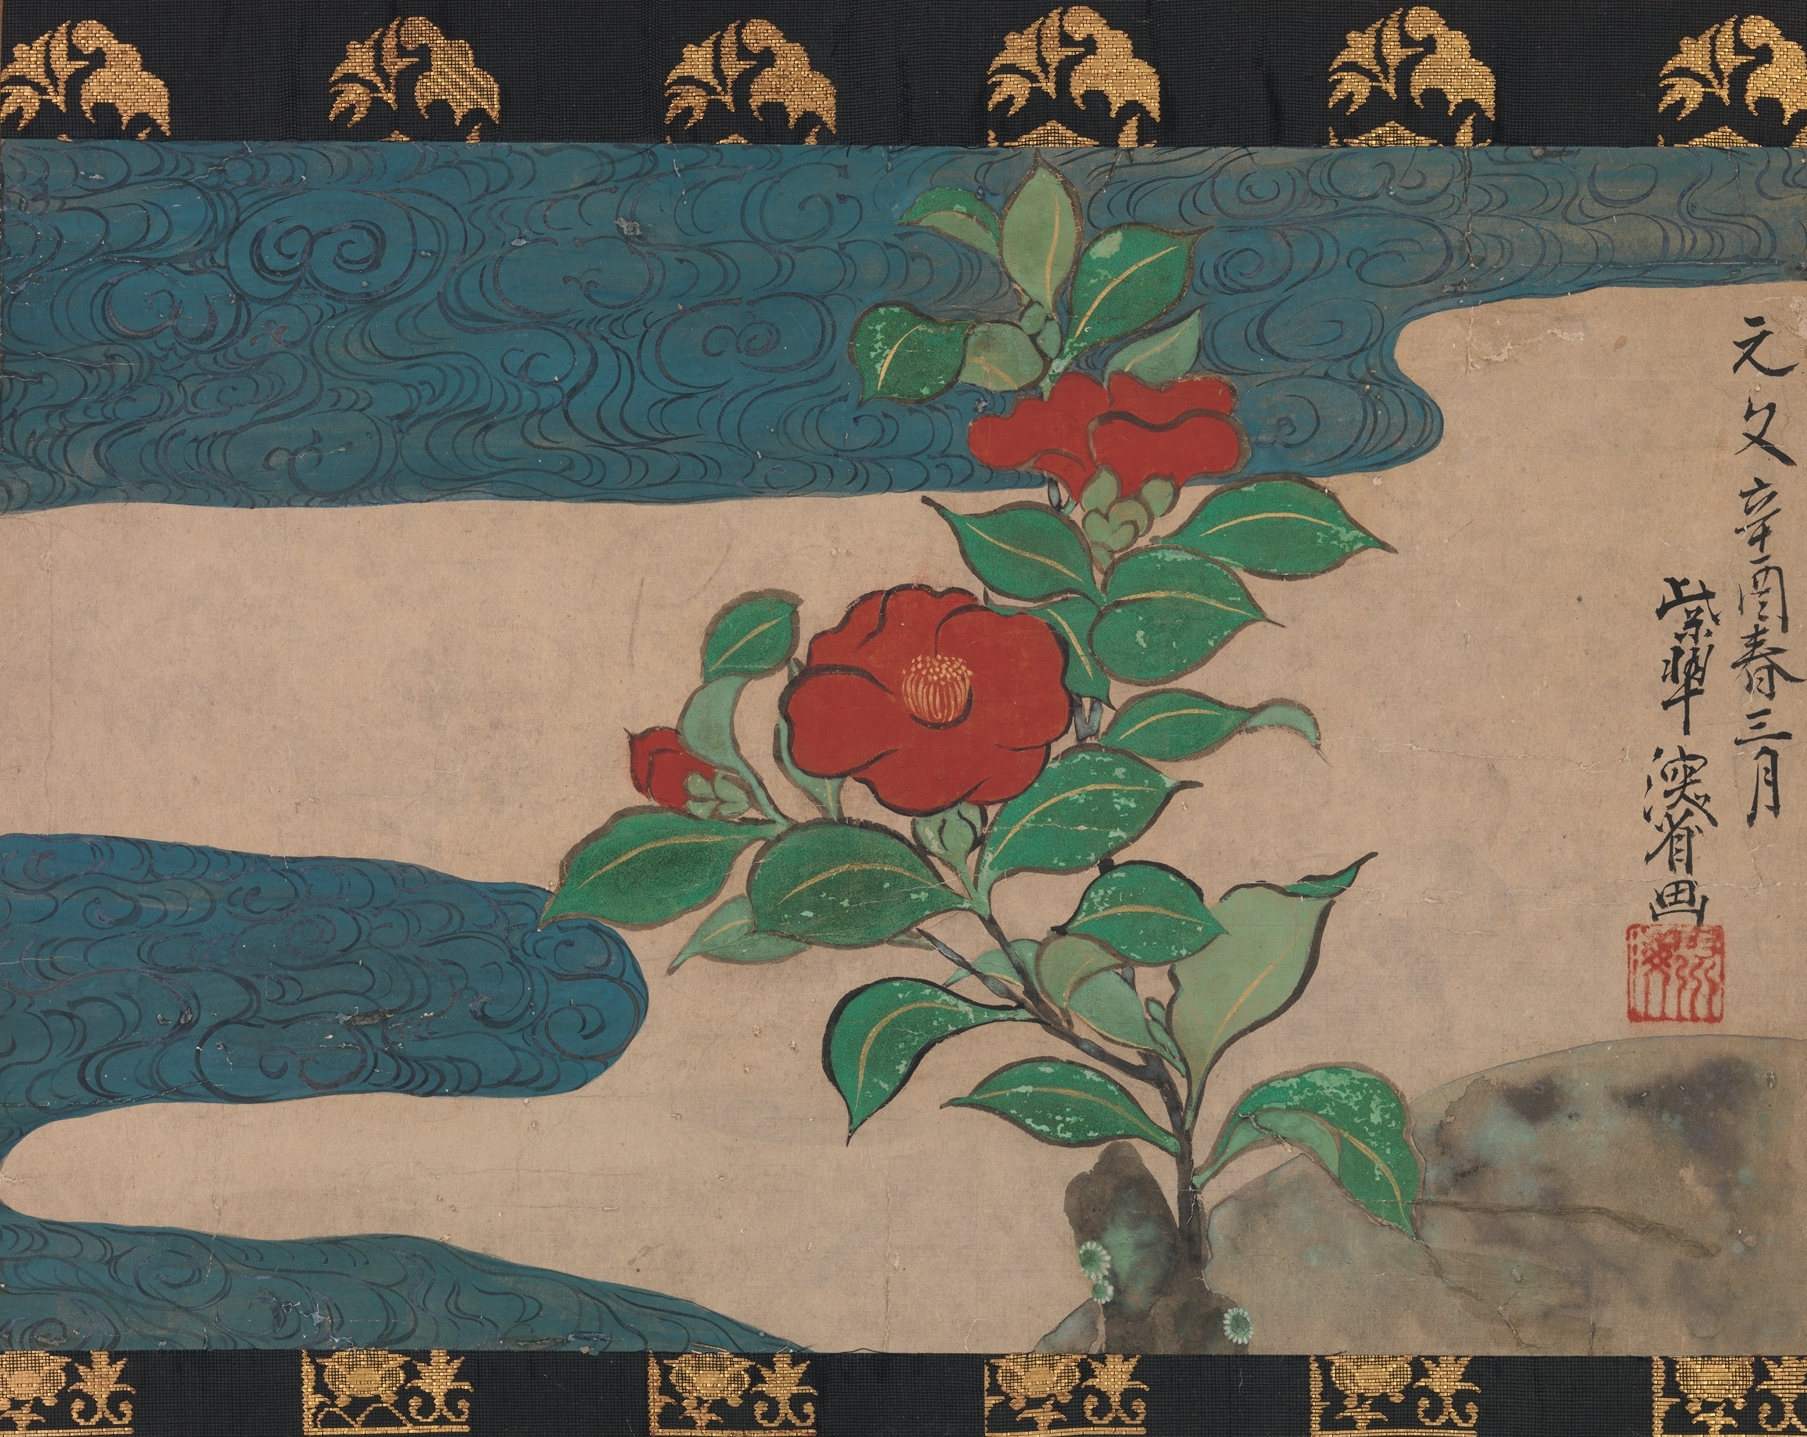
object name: hanging scroll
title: Camellia by Water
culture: japanese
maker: ogata kenzan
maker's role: artist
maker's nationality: japanese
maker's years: 1663-1743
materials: ink, paper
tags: flowers